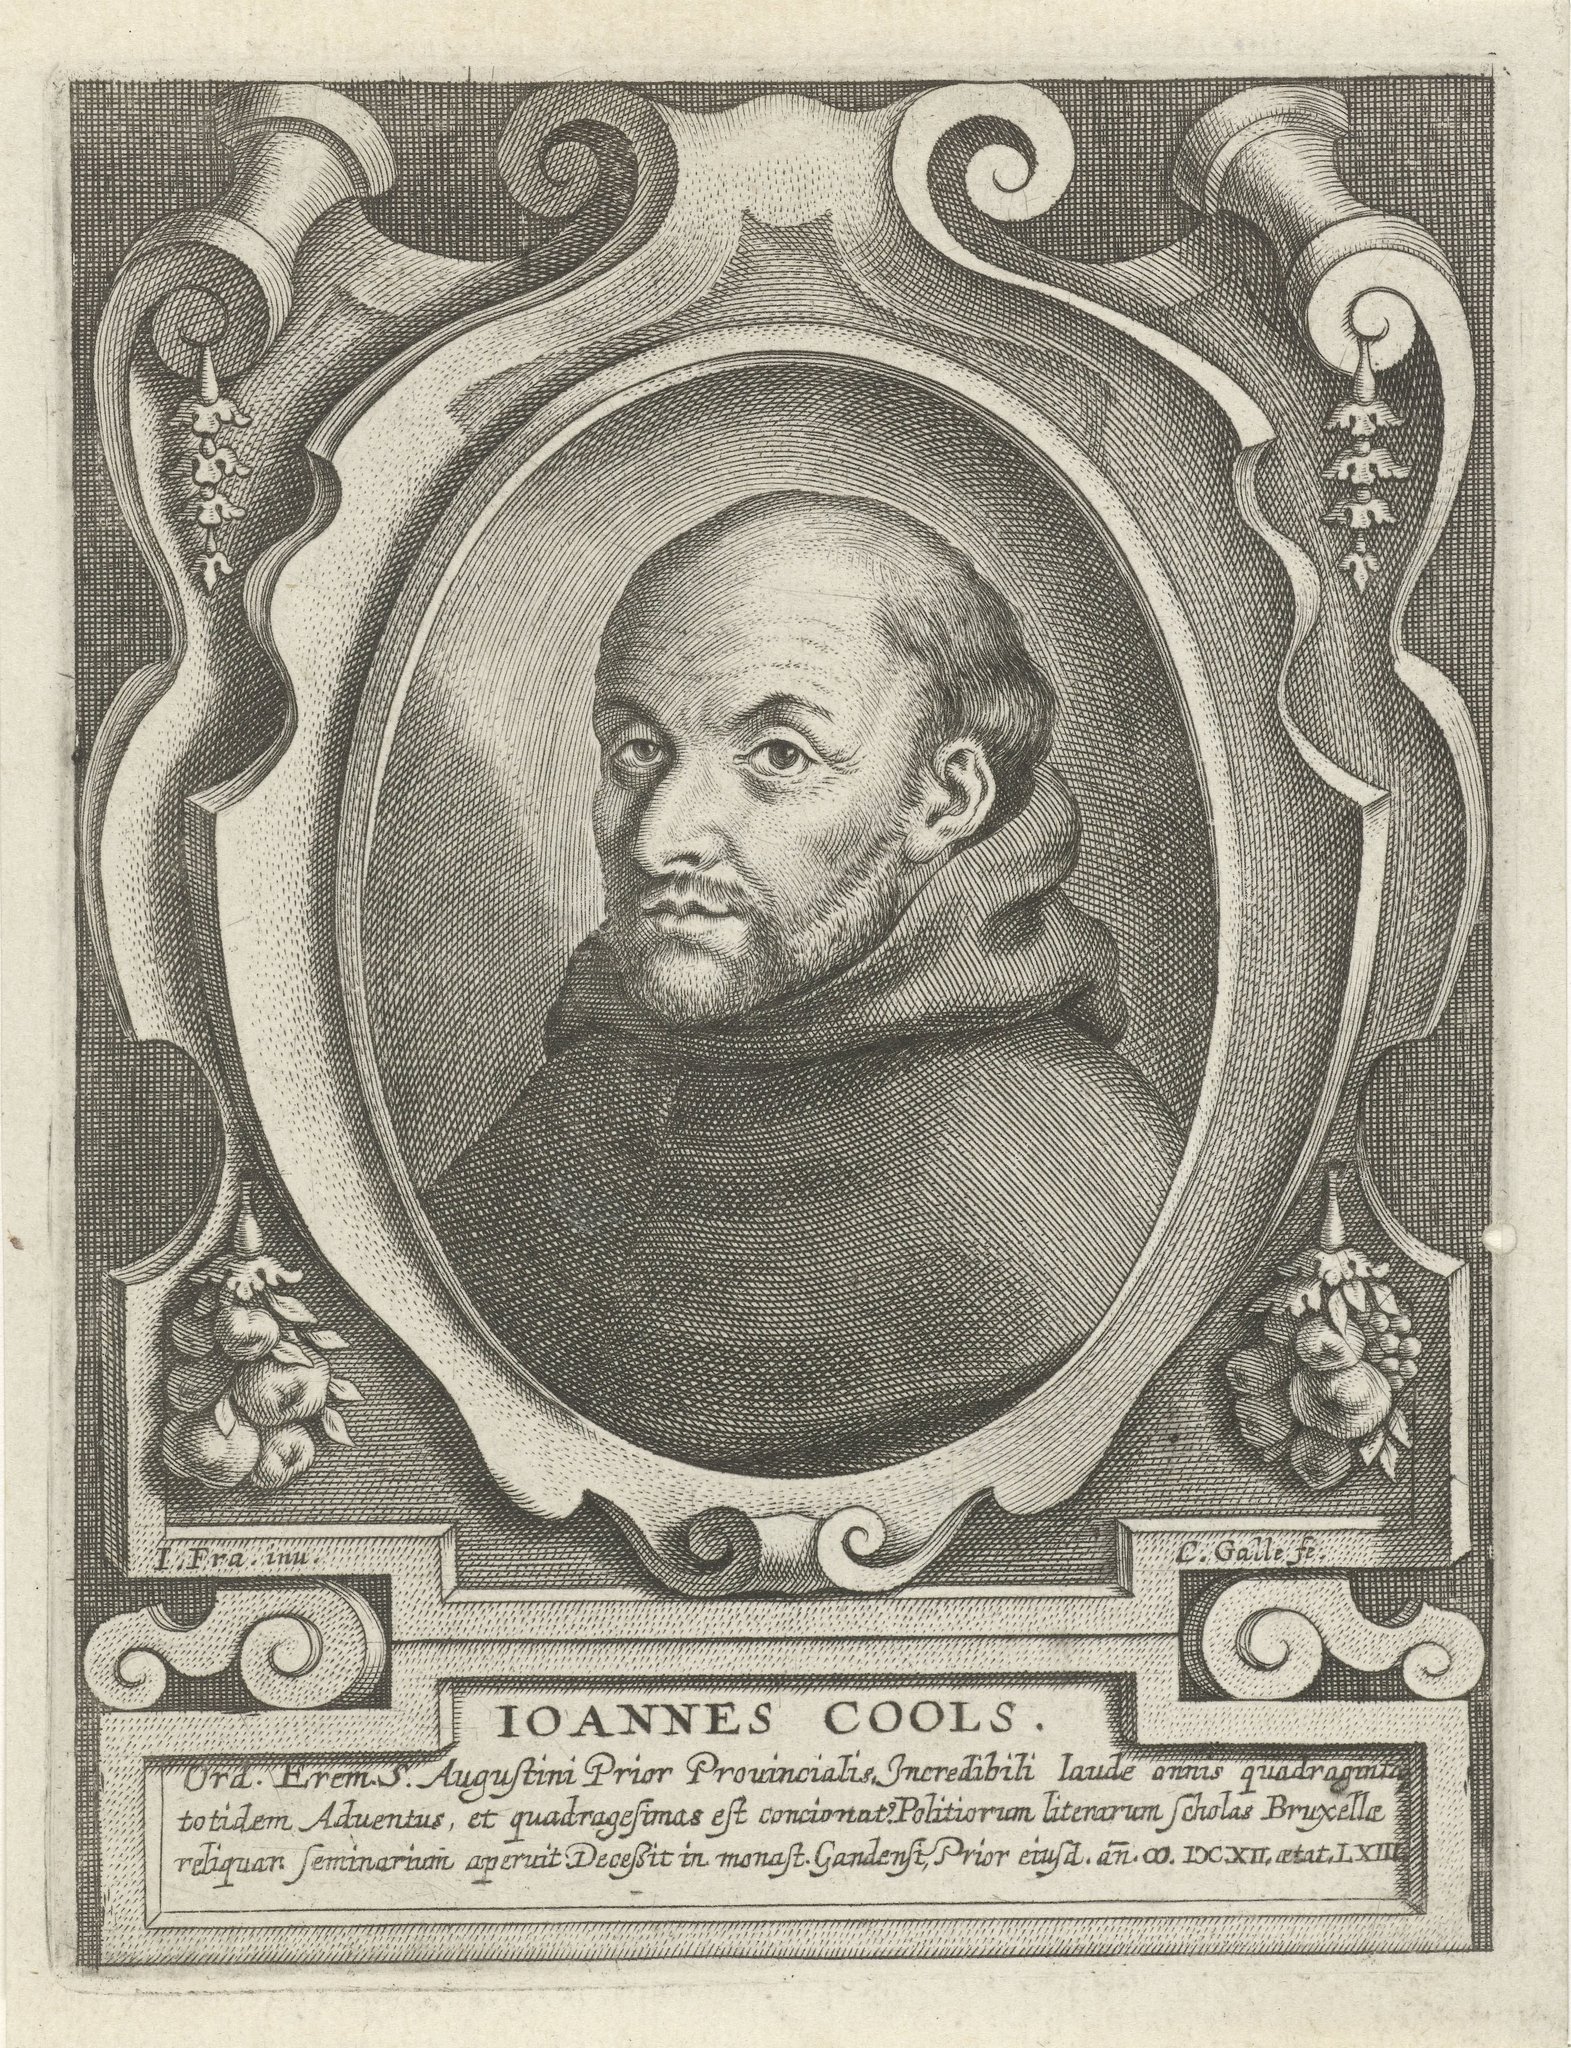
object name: print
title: Portret van de Augustijn Johannes Cools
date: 1636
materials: paper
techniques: engraving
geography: southern netherlands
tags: monastic orders, monastic life ~ roman catholic church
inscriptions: collector's mark: Lugt 2228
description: Boekillustratie voor: C. Curtius, Virorum illustrium ex ordine Eremitarum D. Augustini elogia , Antwerpen: J. Cnobbaert, 1636.